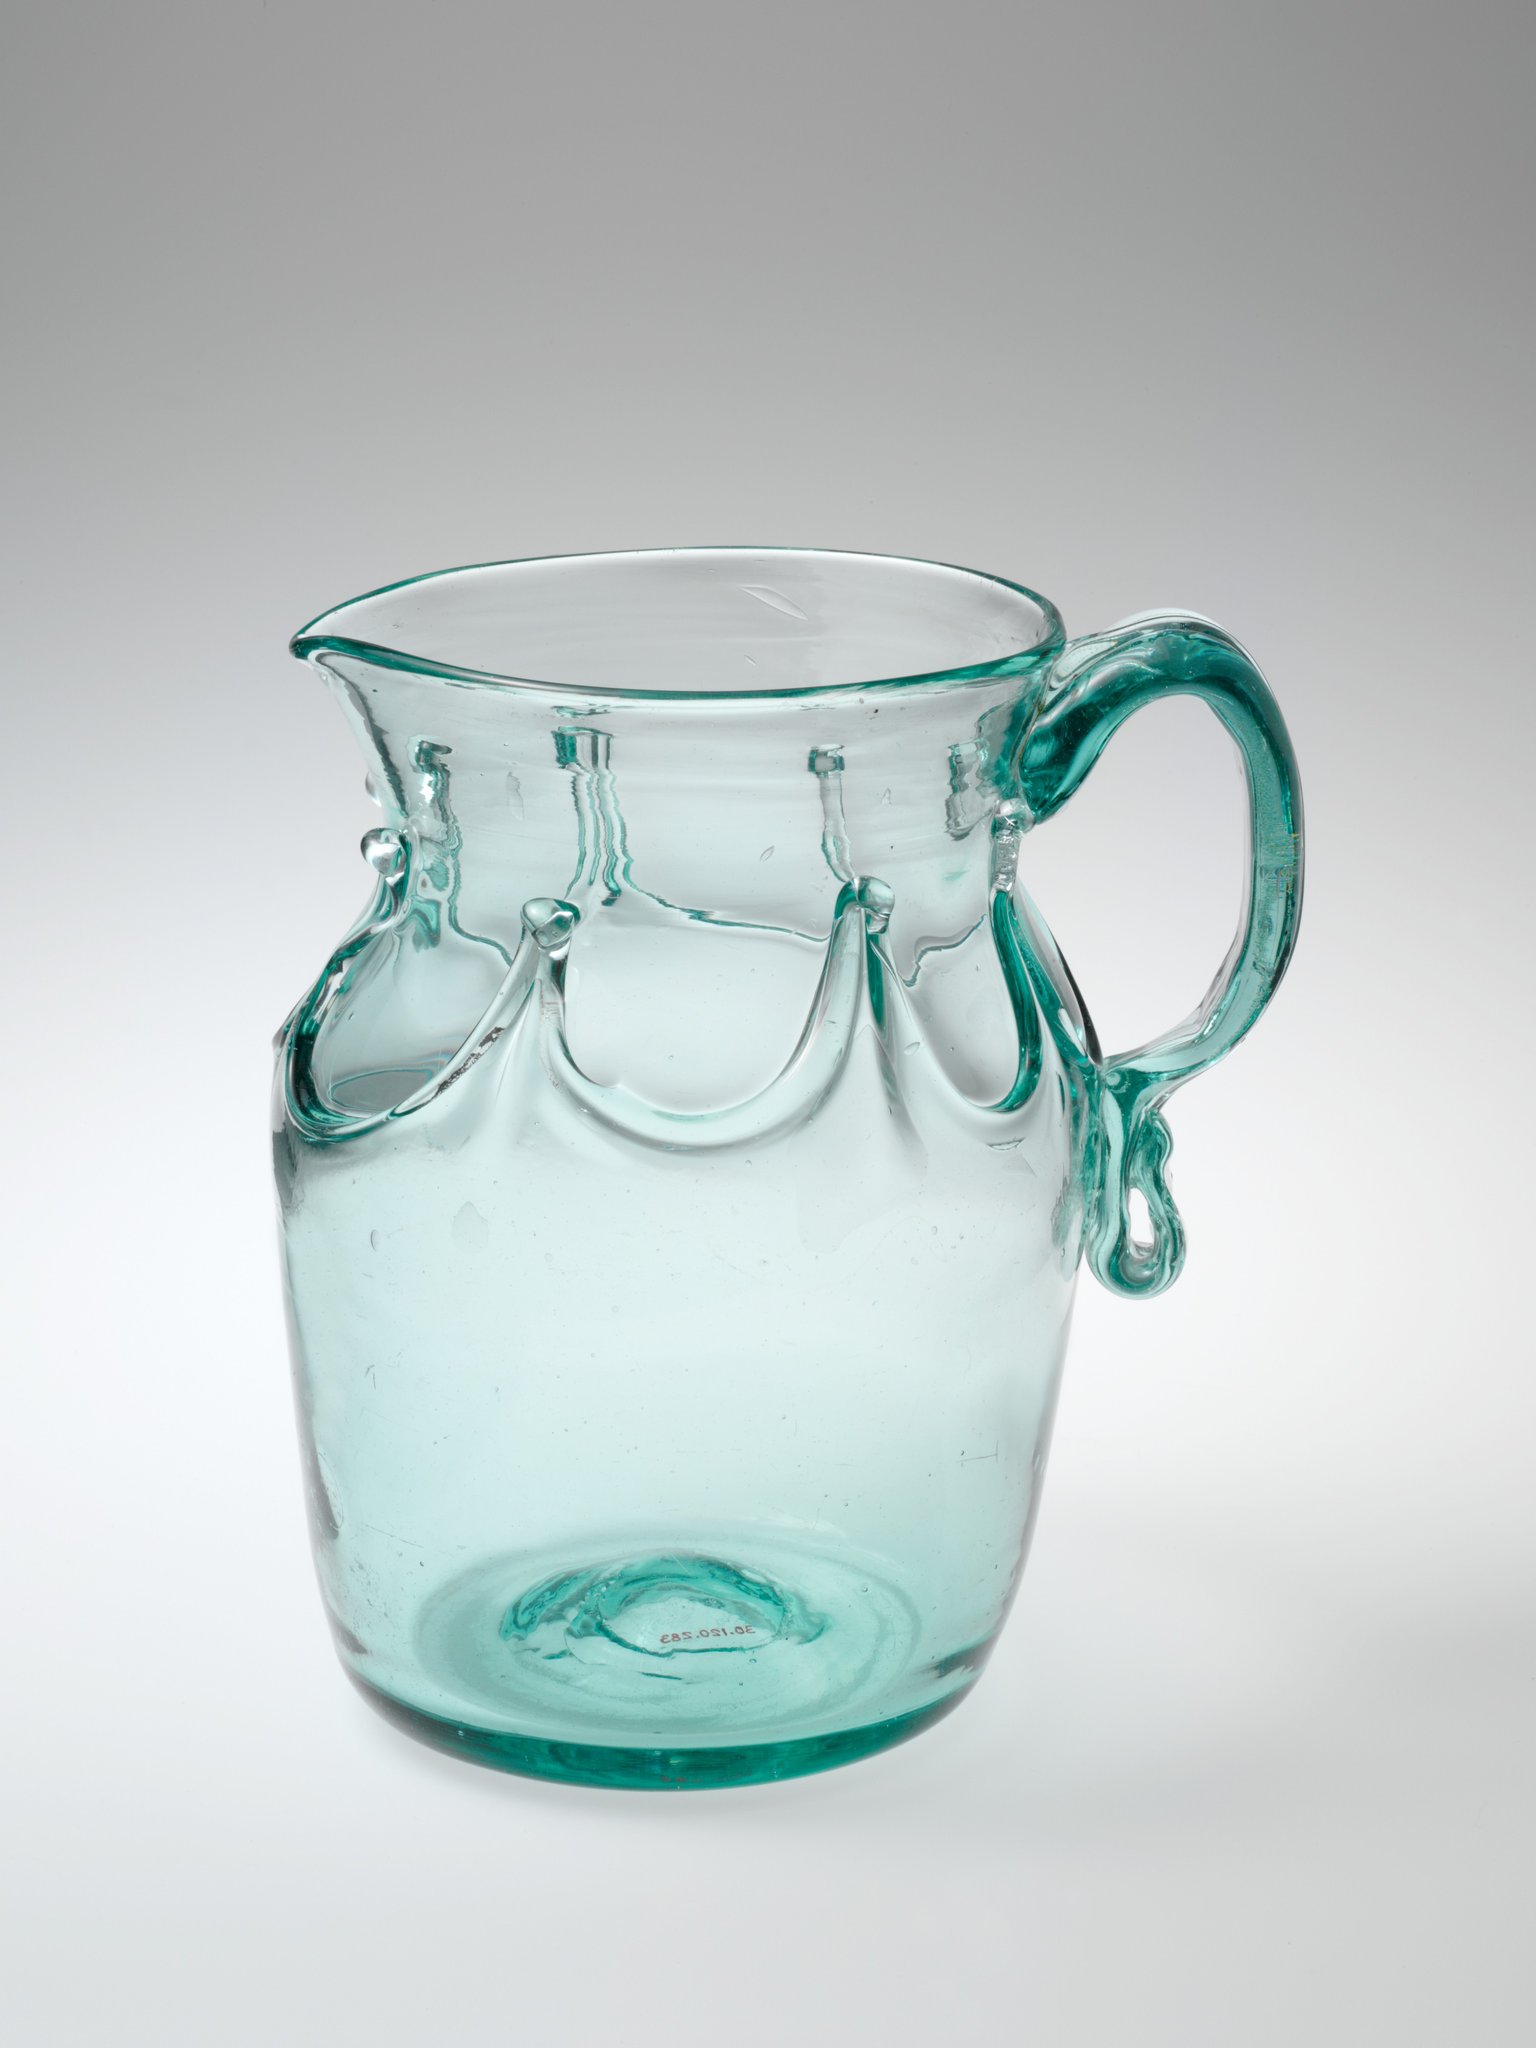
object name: pitcher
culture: american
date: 1835-1865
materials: glass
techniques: glassblowing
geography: united states